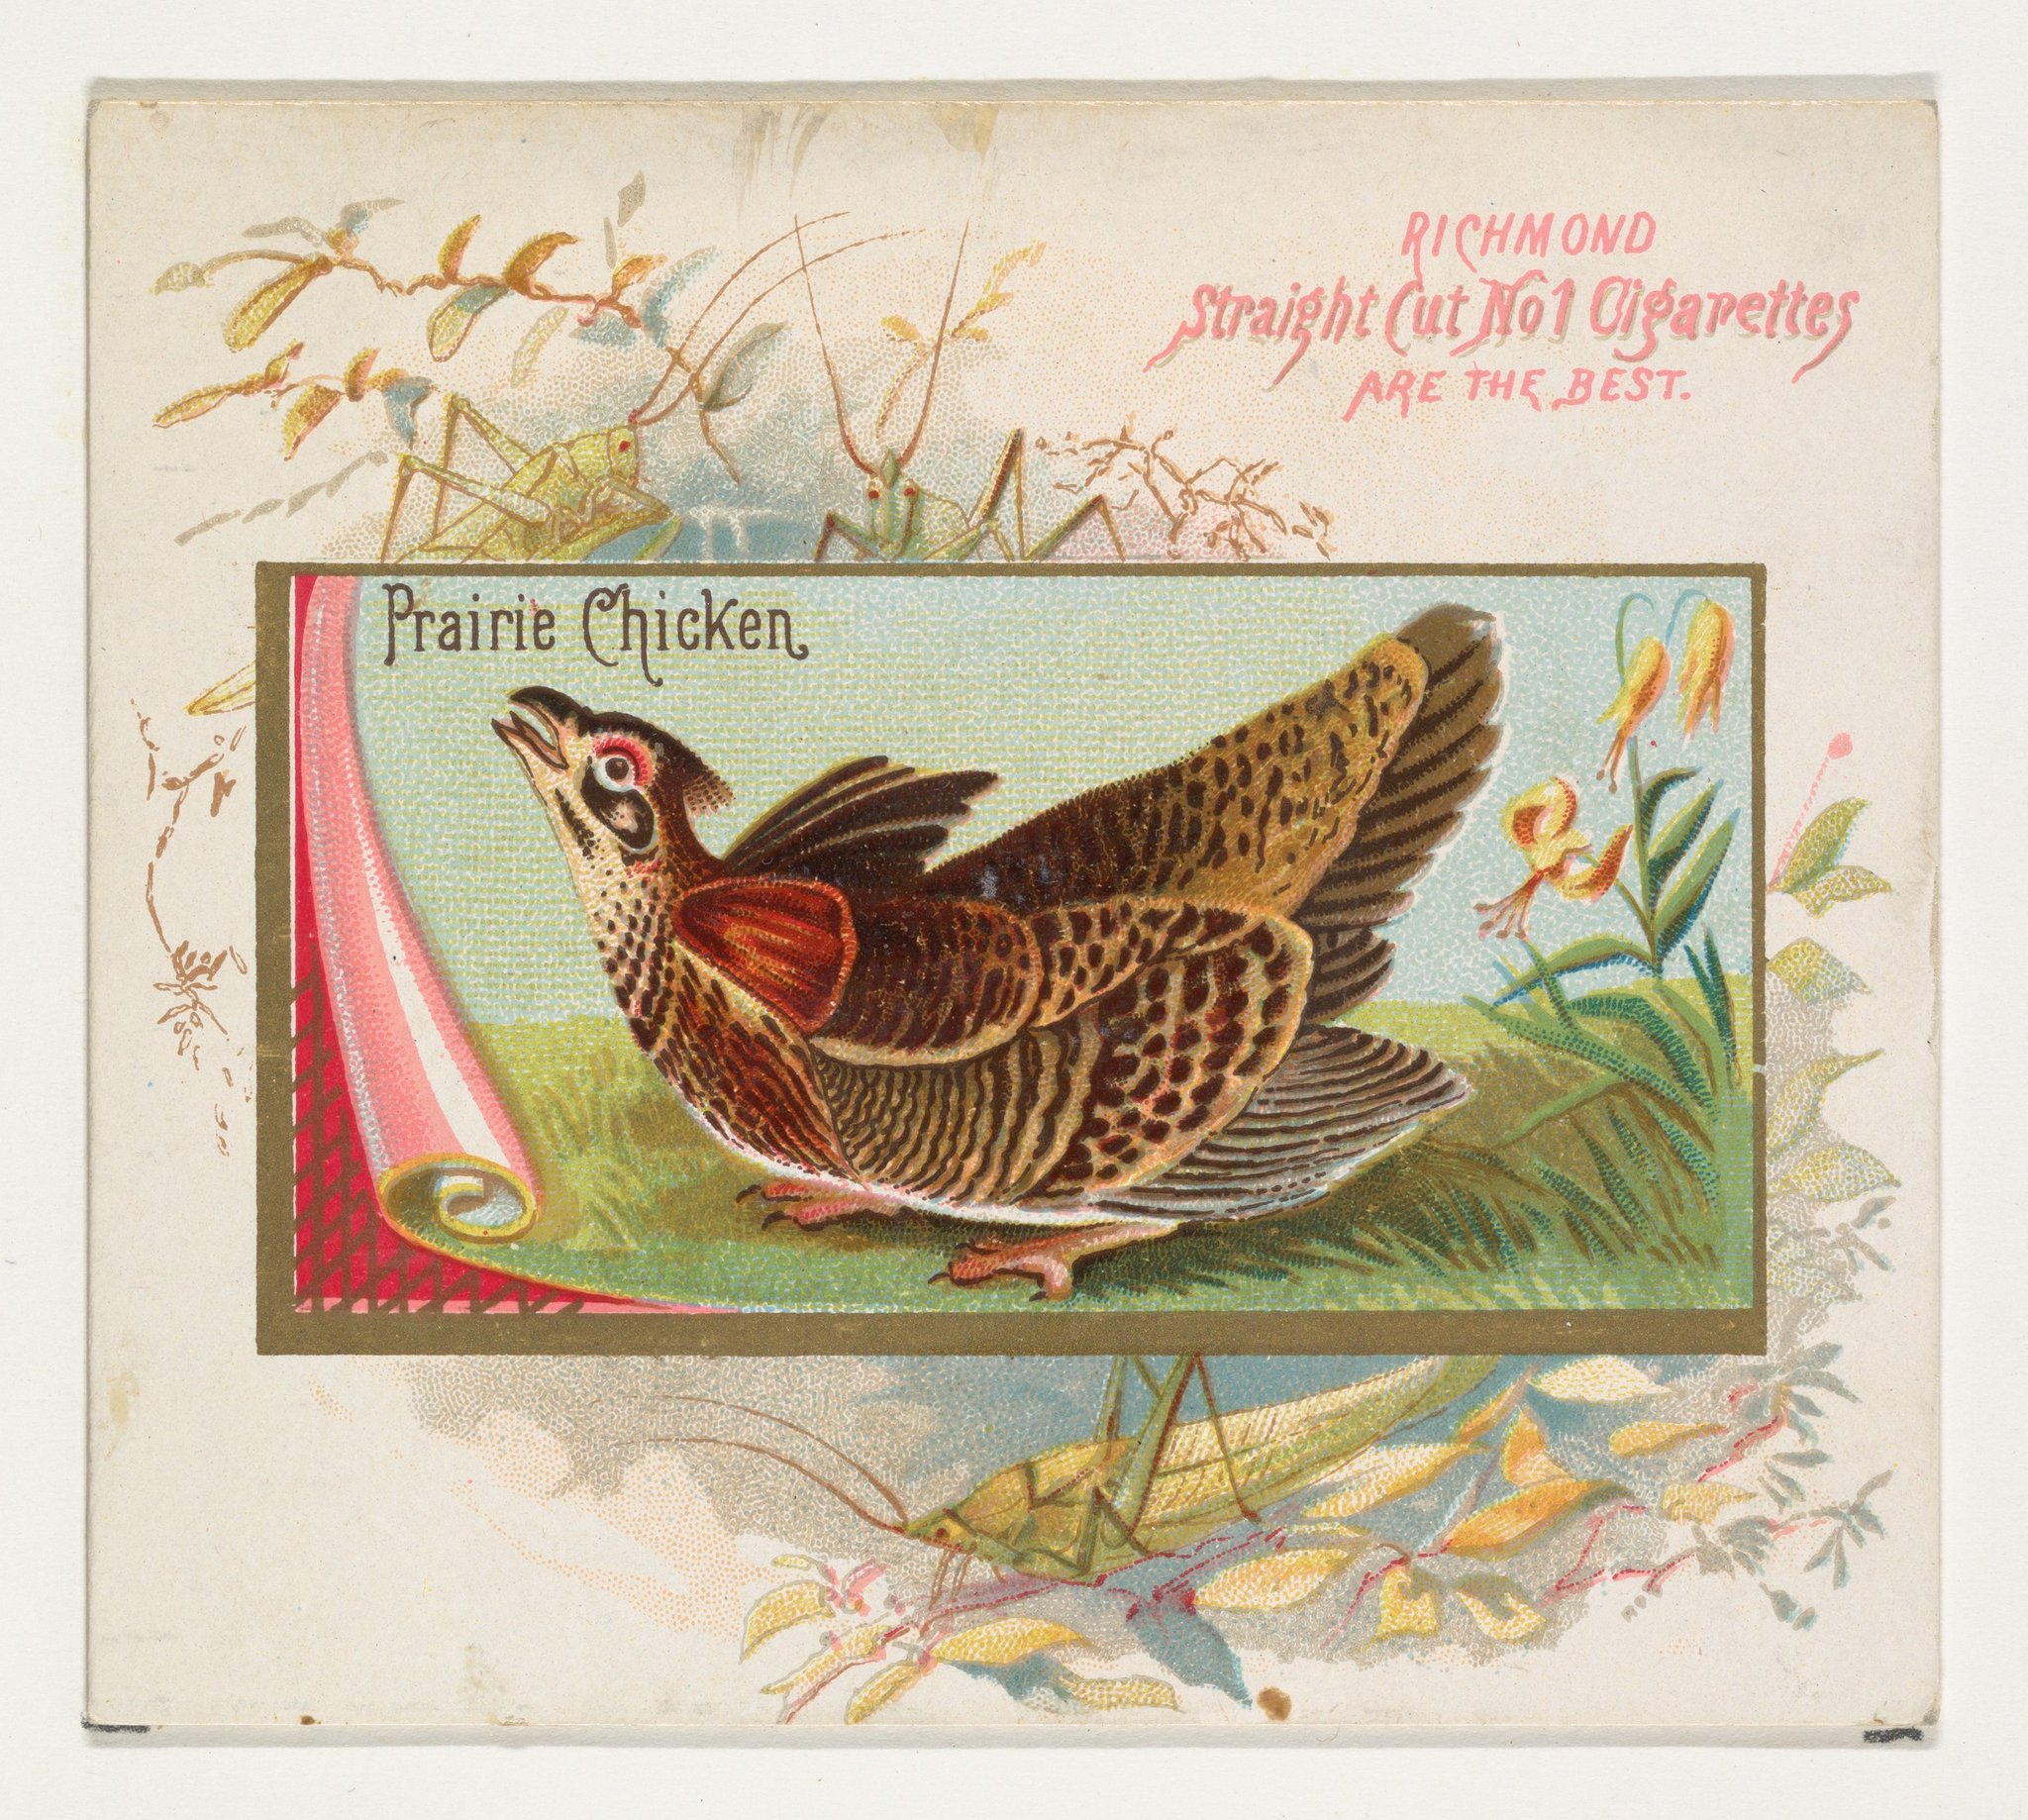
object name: print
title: Prairie Chicken, from the Game Birds series (N40) for Allen & Ginter Cigarettes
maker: allen & ginter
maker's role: publisher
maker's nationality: american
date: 1888-1890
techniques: color lithograph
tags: birds